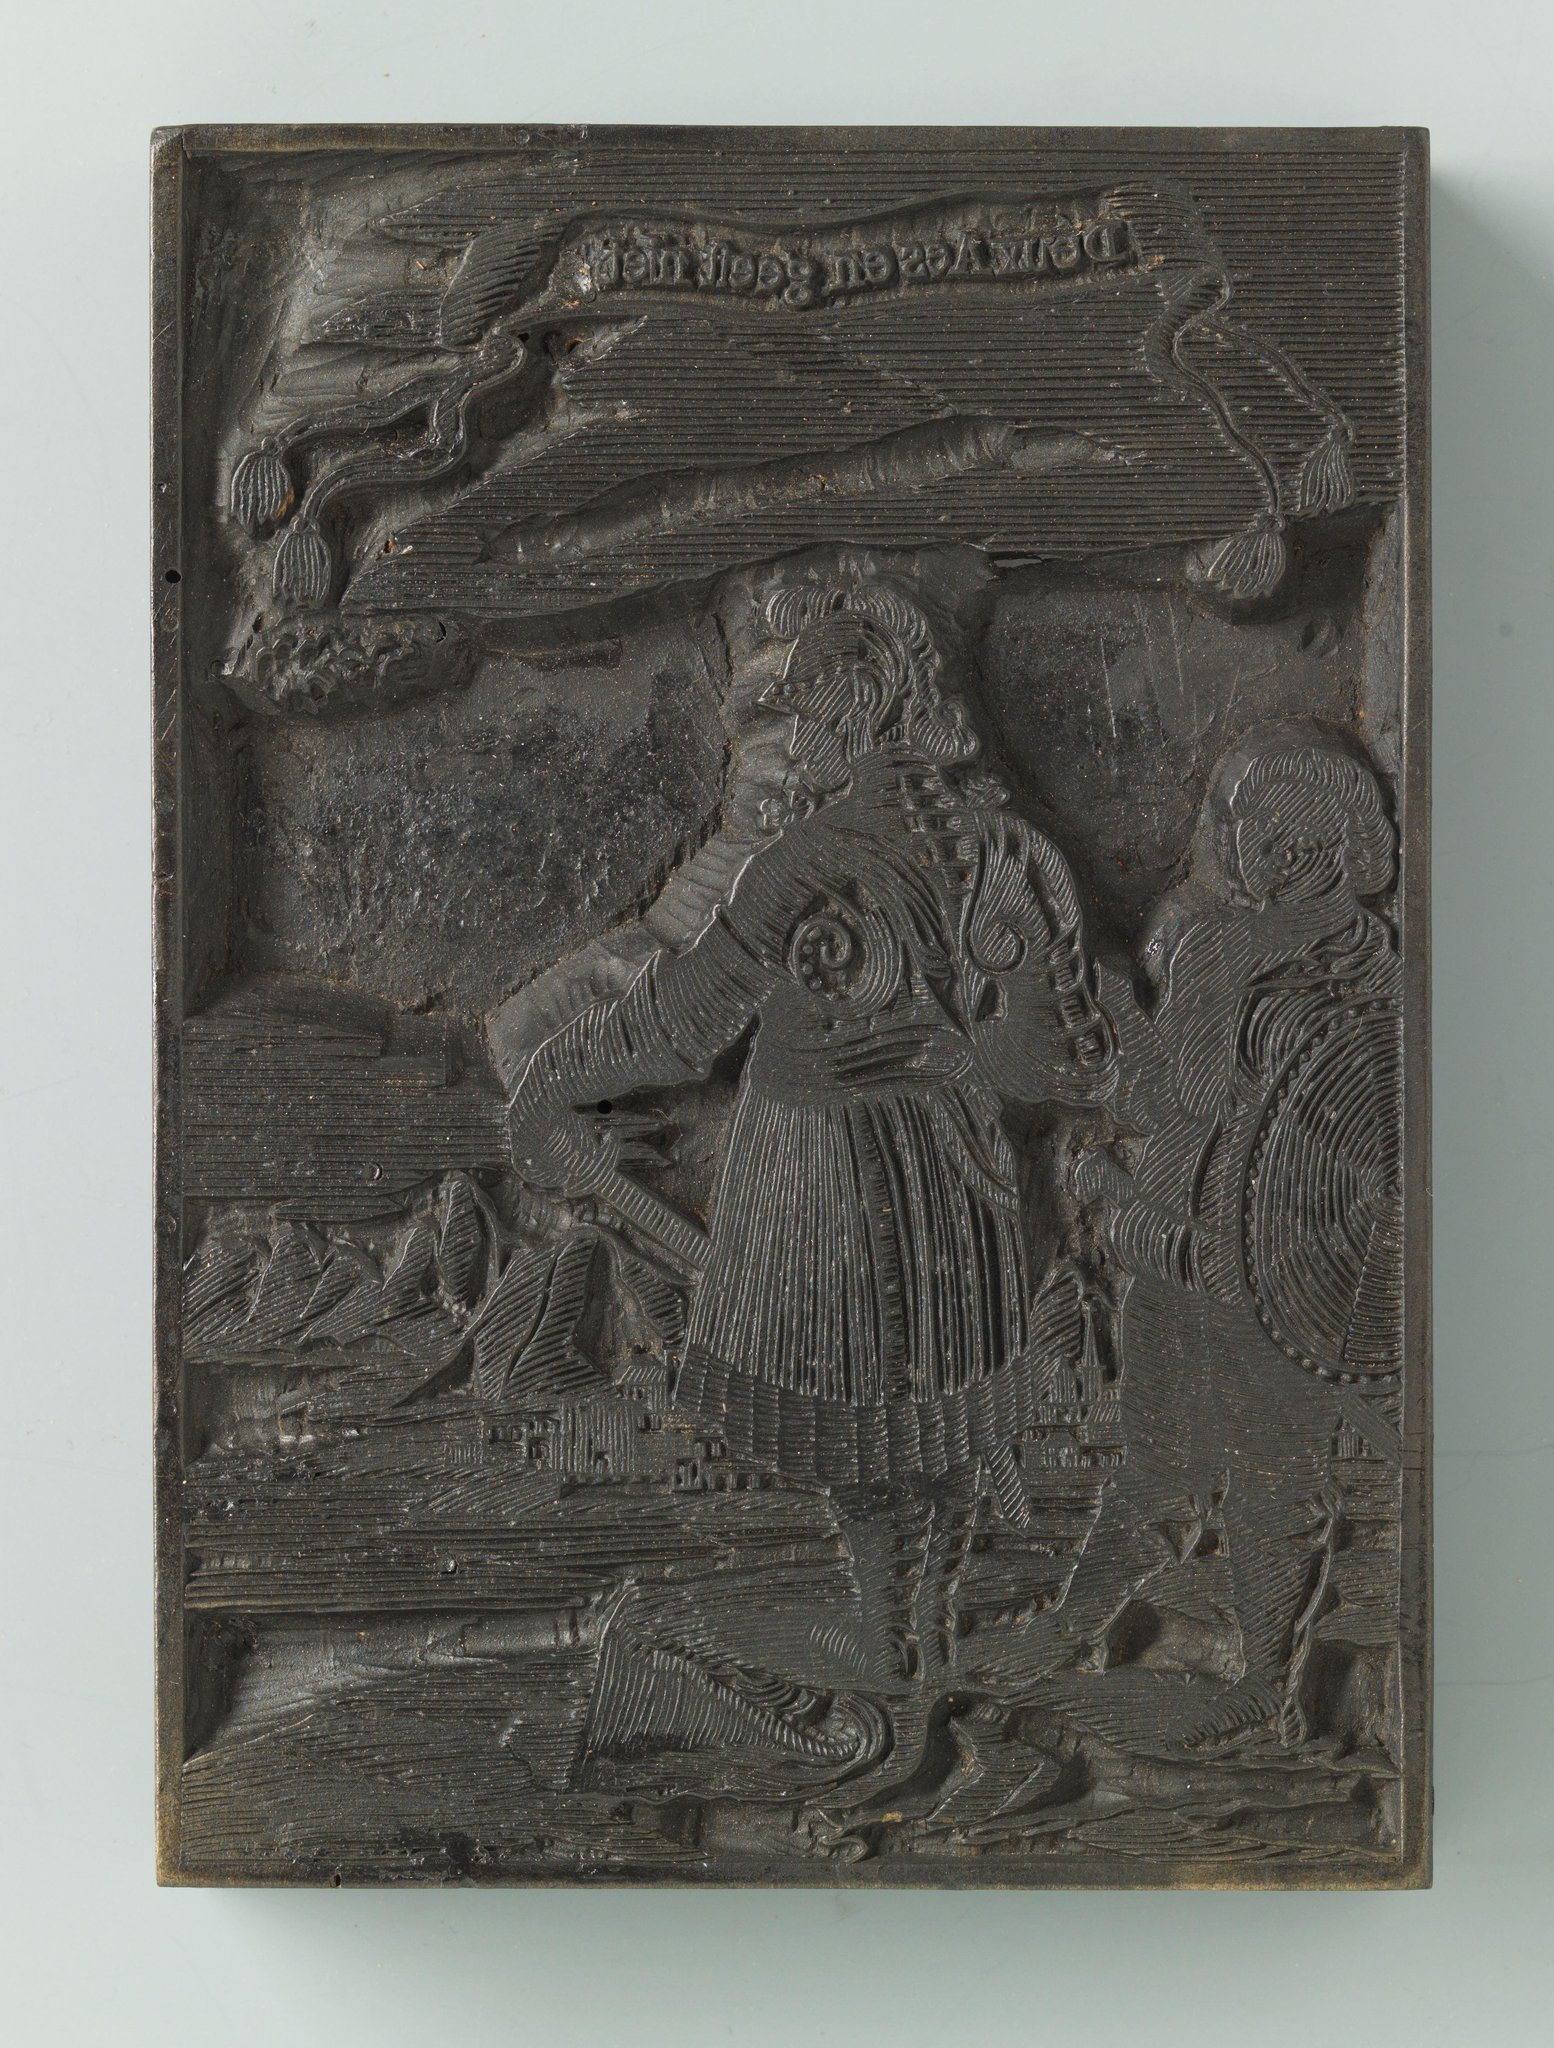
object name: wood block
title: Deux Aes en geeft niet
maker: Anonymous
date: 1819-1851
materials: wood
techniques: woodcut